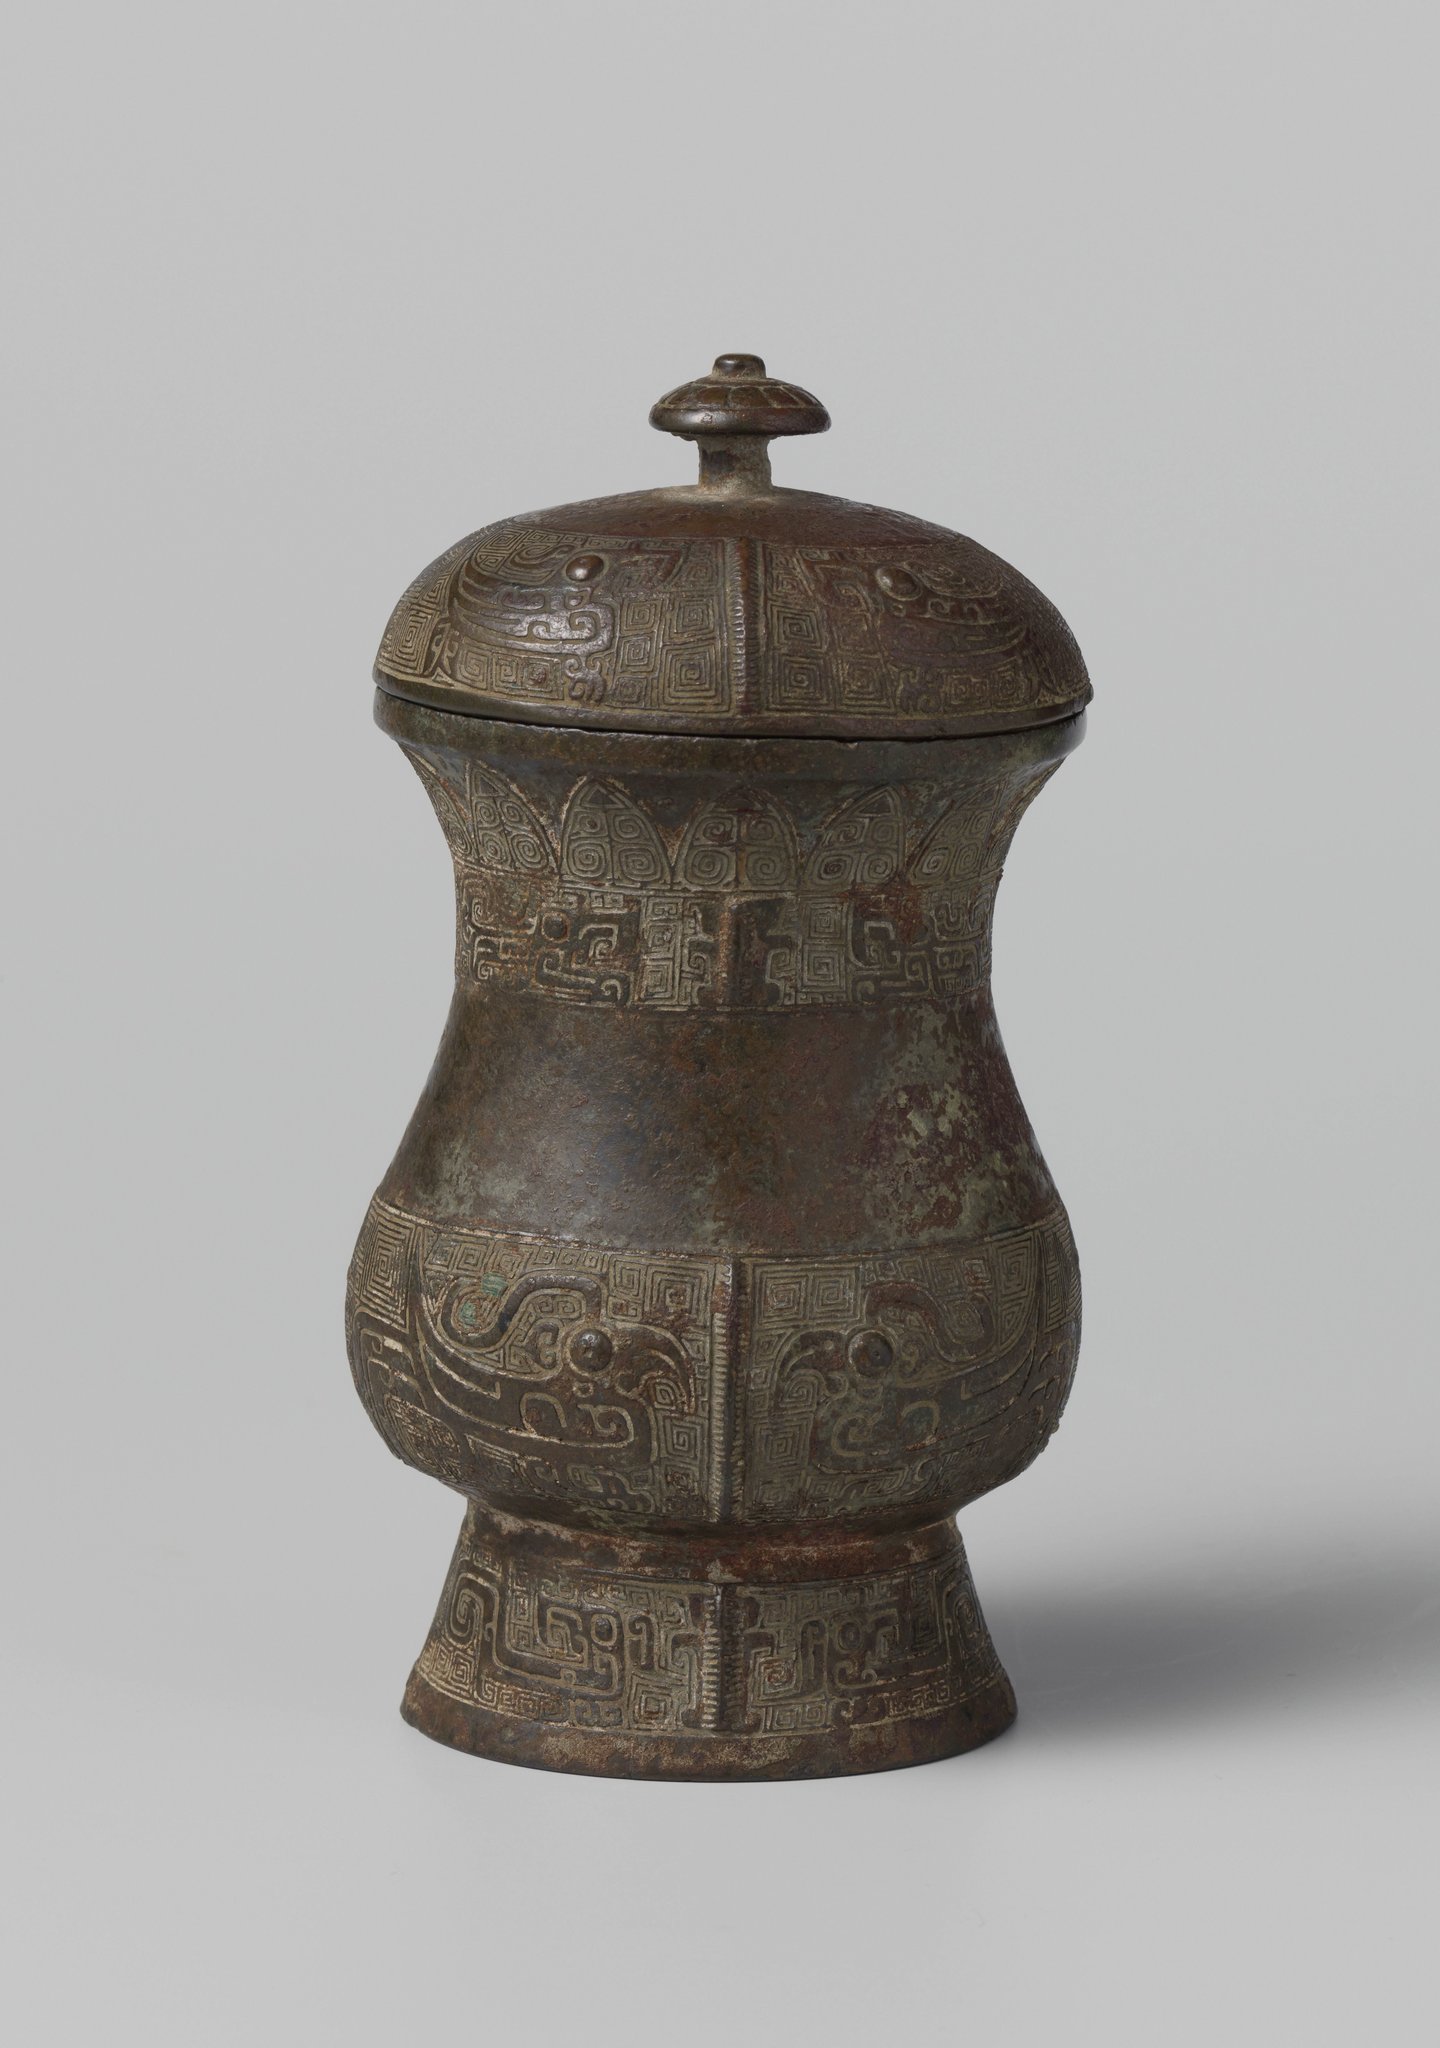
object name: wine cup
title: Ritual winecup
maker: Anonymous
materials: bronze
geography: china